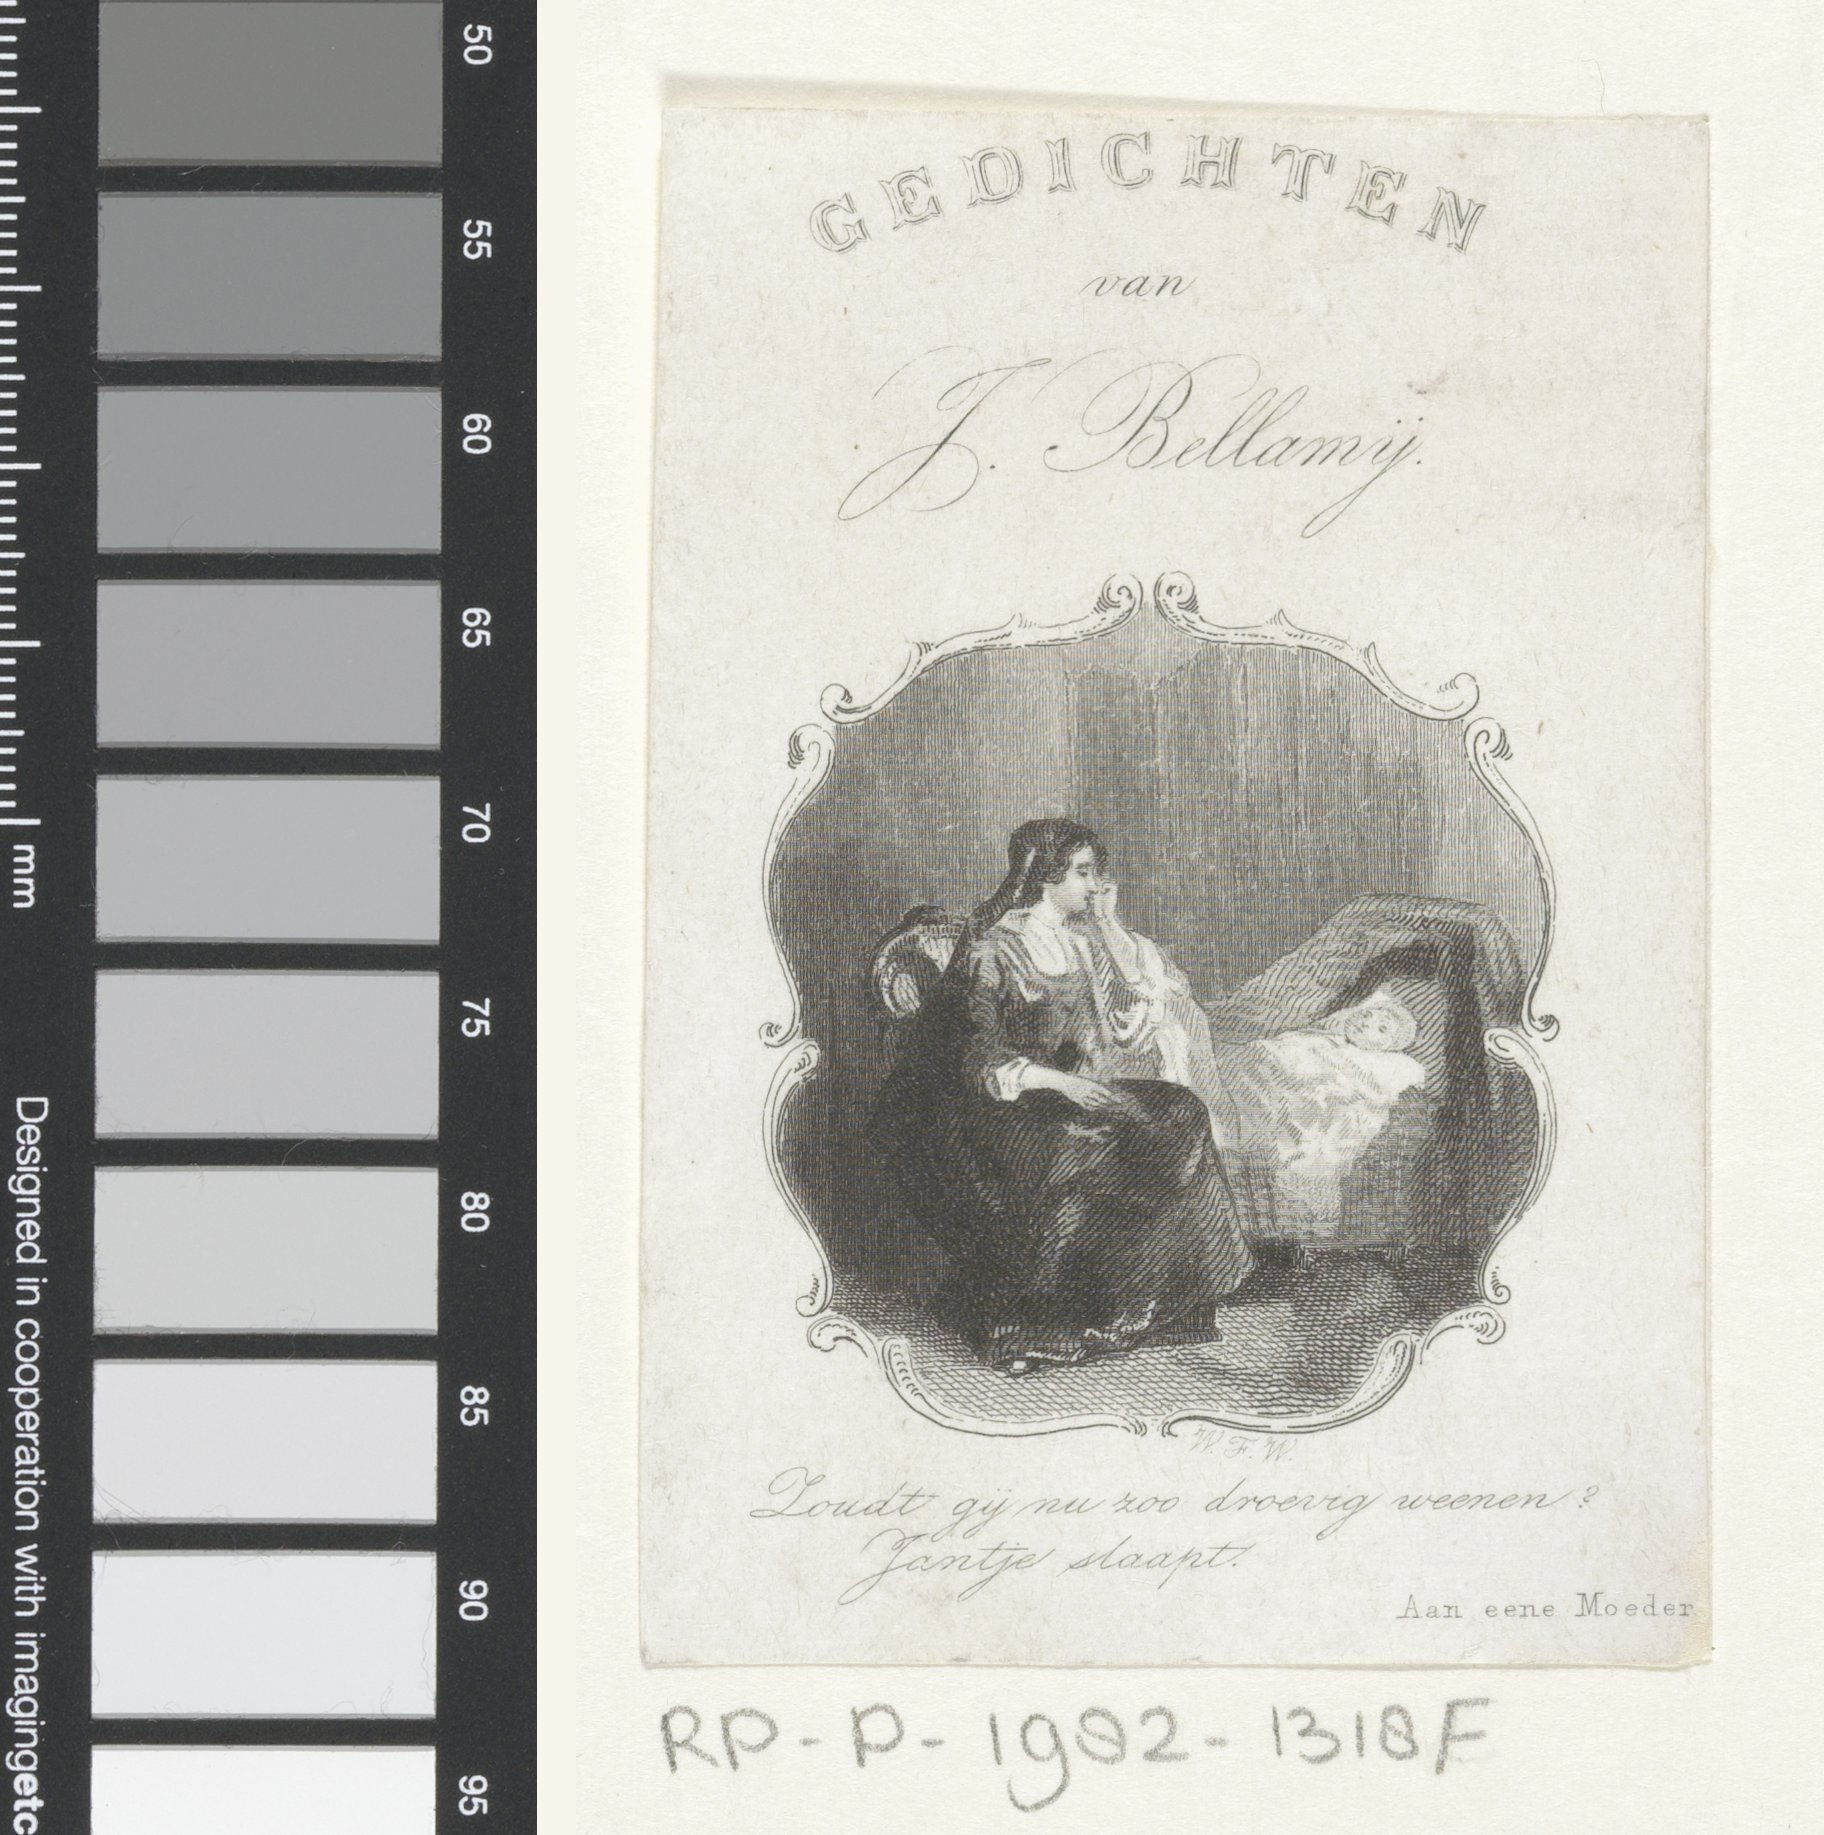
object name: print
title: Titelpagina voor: Jacobus Bellamy, Gedichten, 1852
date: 1852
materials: paper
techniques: engraving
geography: haarlem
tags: mother and son(s) (family group)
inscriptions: collector's mark: Lugt 2760, collector's mark: Lugt 2228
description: Titelpagina voor: Bellamy, Jacobus. Gedichten. Haarlem: Kruseman, Arie Cornelis, 1852.